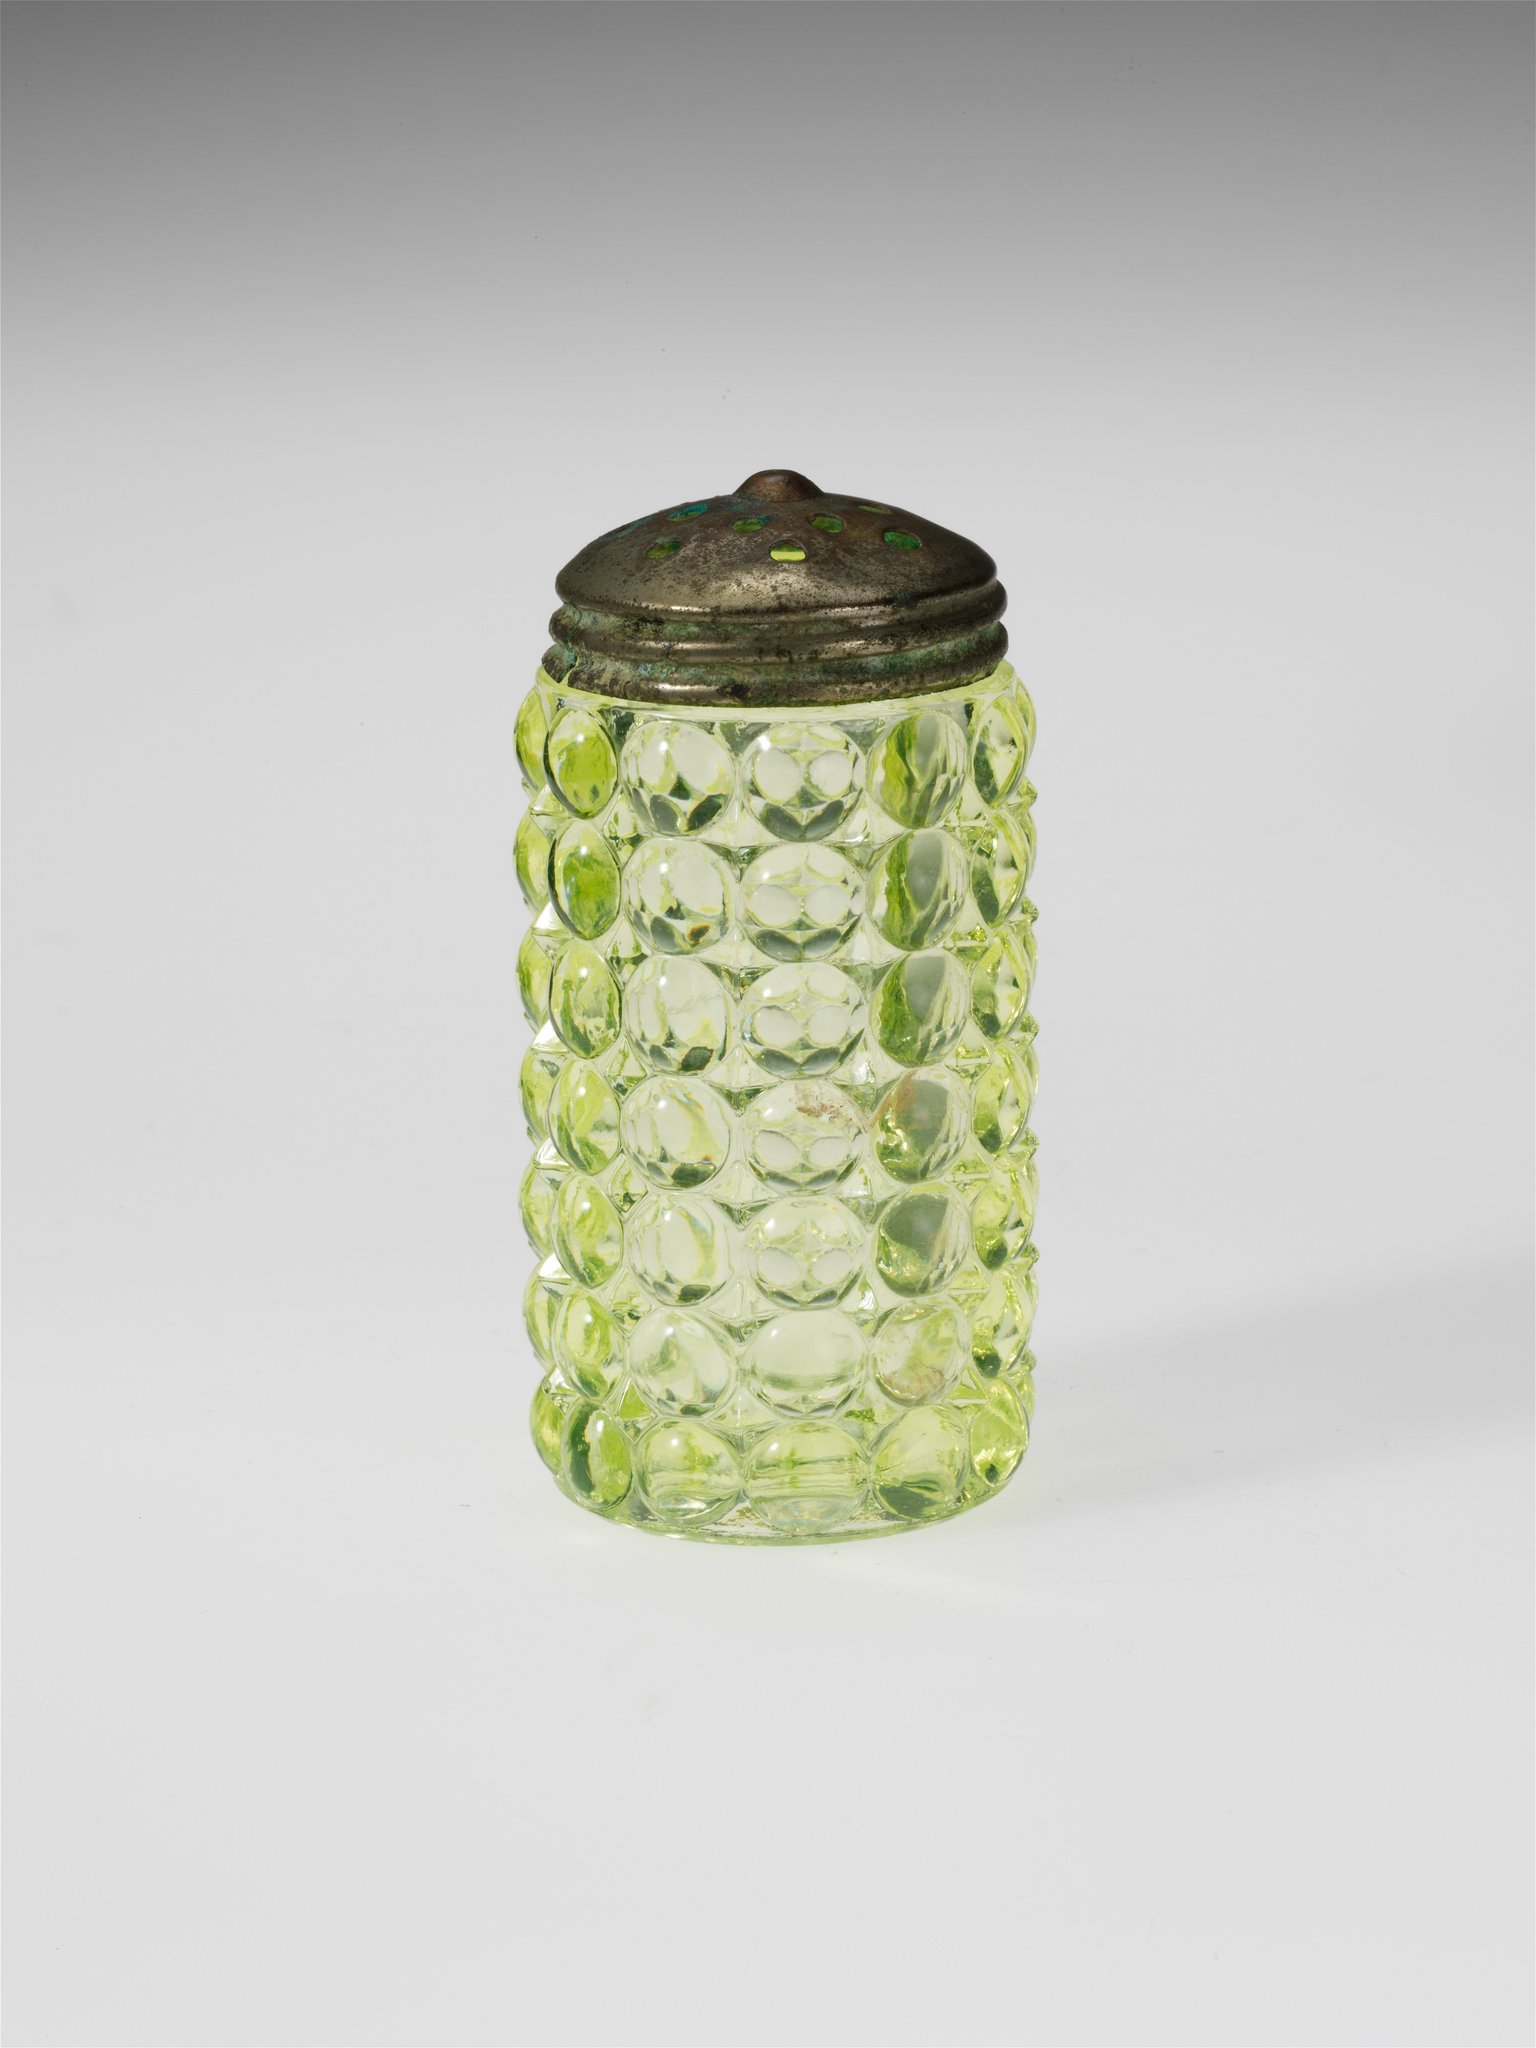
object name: pepper caster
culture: american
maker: richards and hartley flint glass co.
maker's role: maker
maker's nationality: american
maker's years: 1867-1890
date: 1888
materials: glass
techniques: pressed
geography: united states